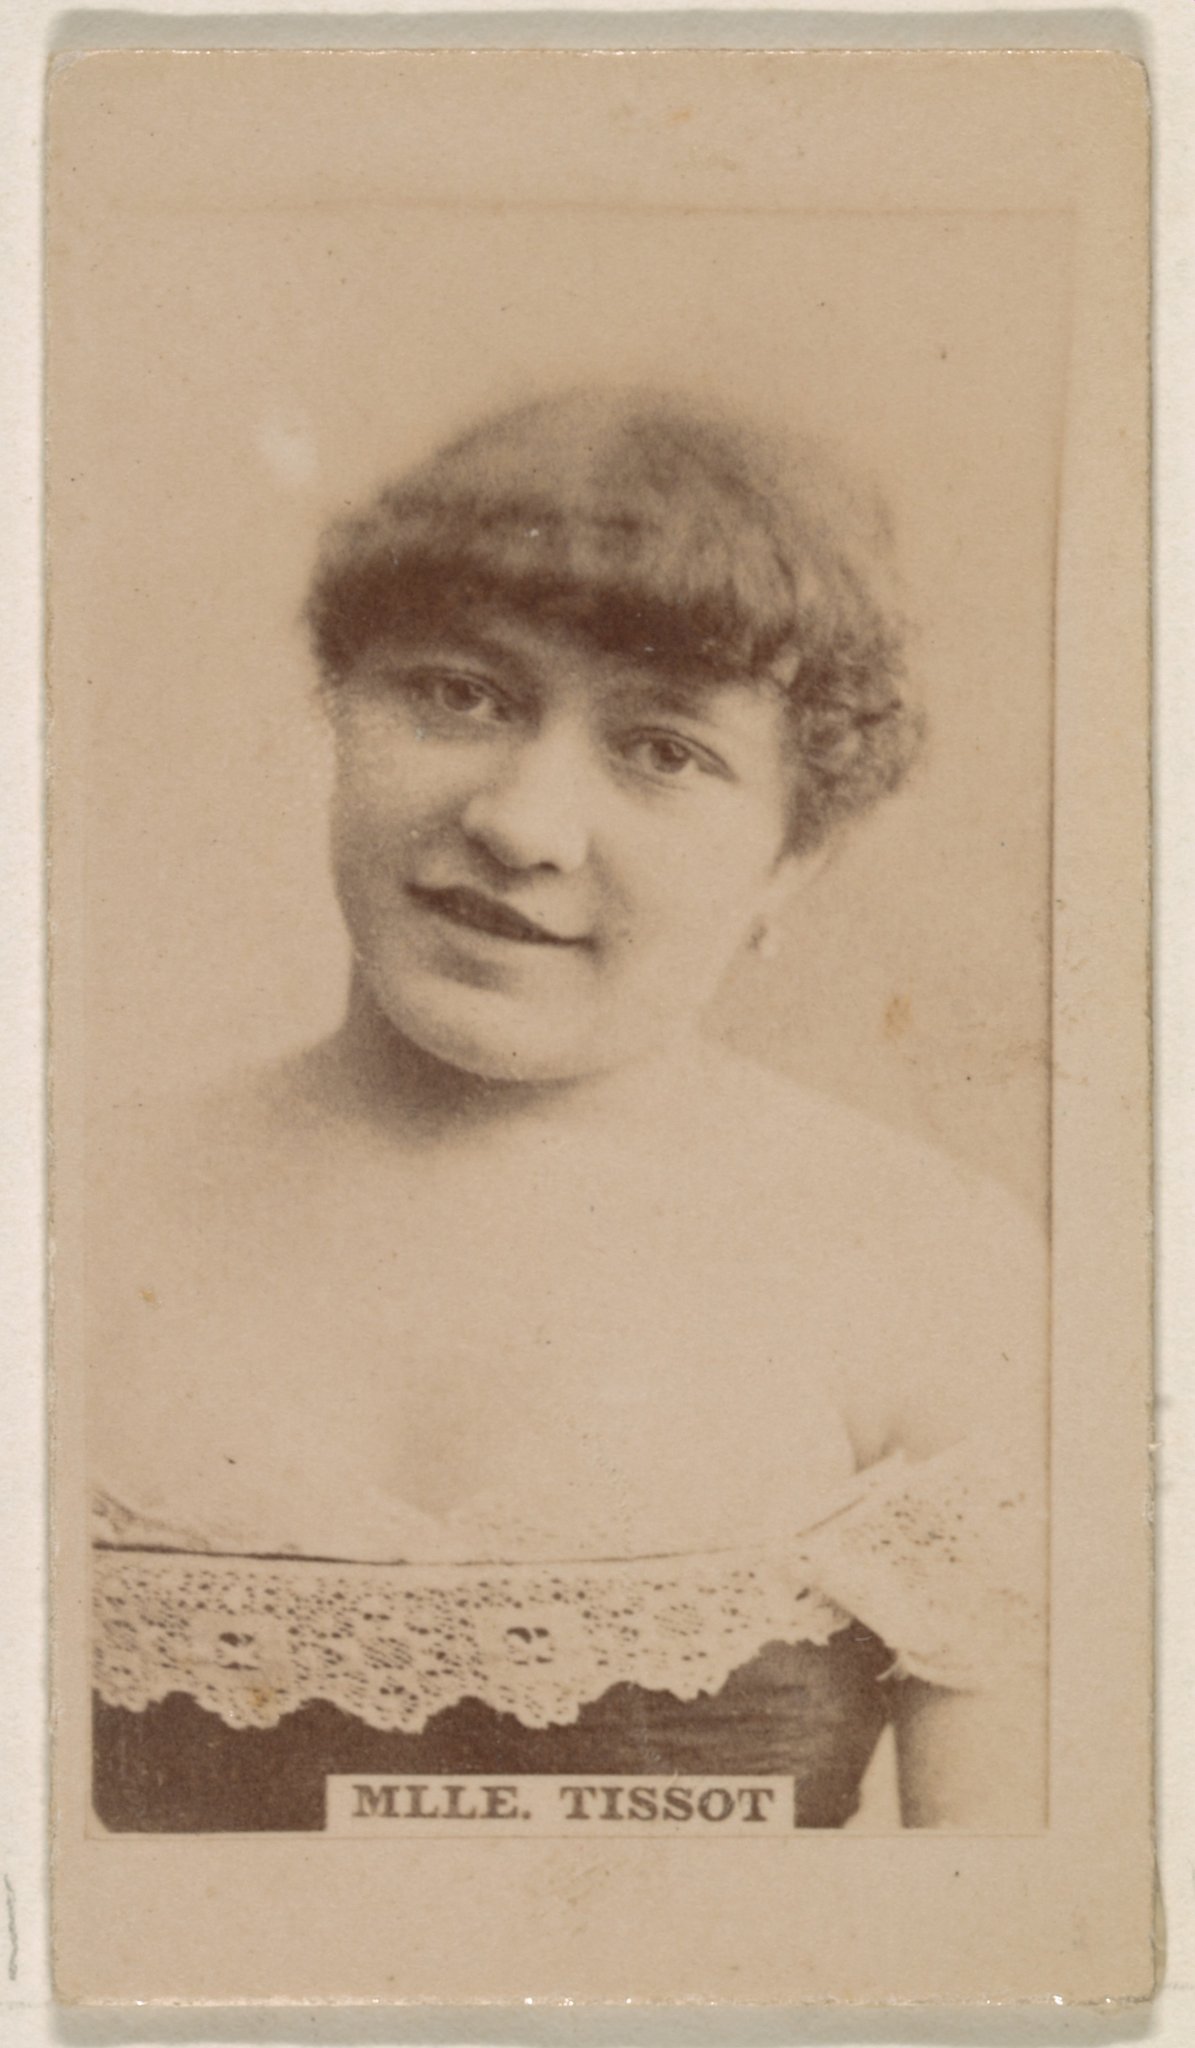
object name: photograph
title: Mlle. Tissot, from the Actresses series (N245) issued by Kinney Brothers to promote Sweet Caporal Cigarettes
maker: kinney brothers tobacco company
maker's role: publisher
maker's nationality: american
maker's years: 1869-2011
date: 1890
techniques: albumen silver print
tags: portraits,women,actresses